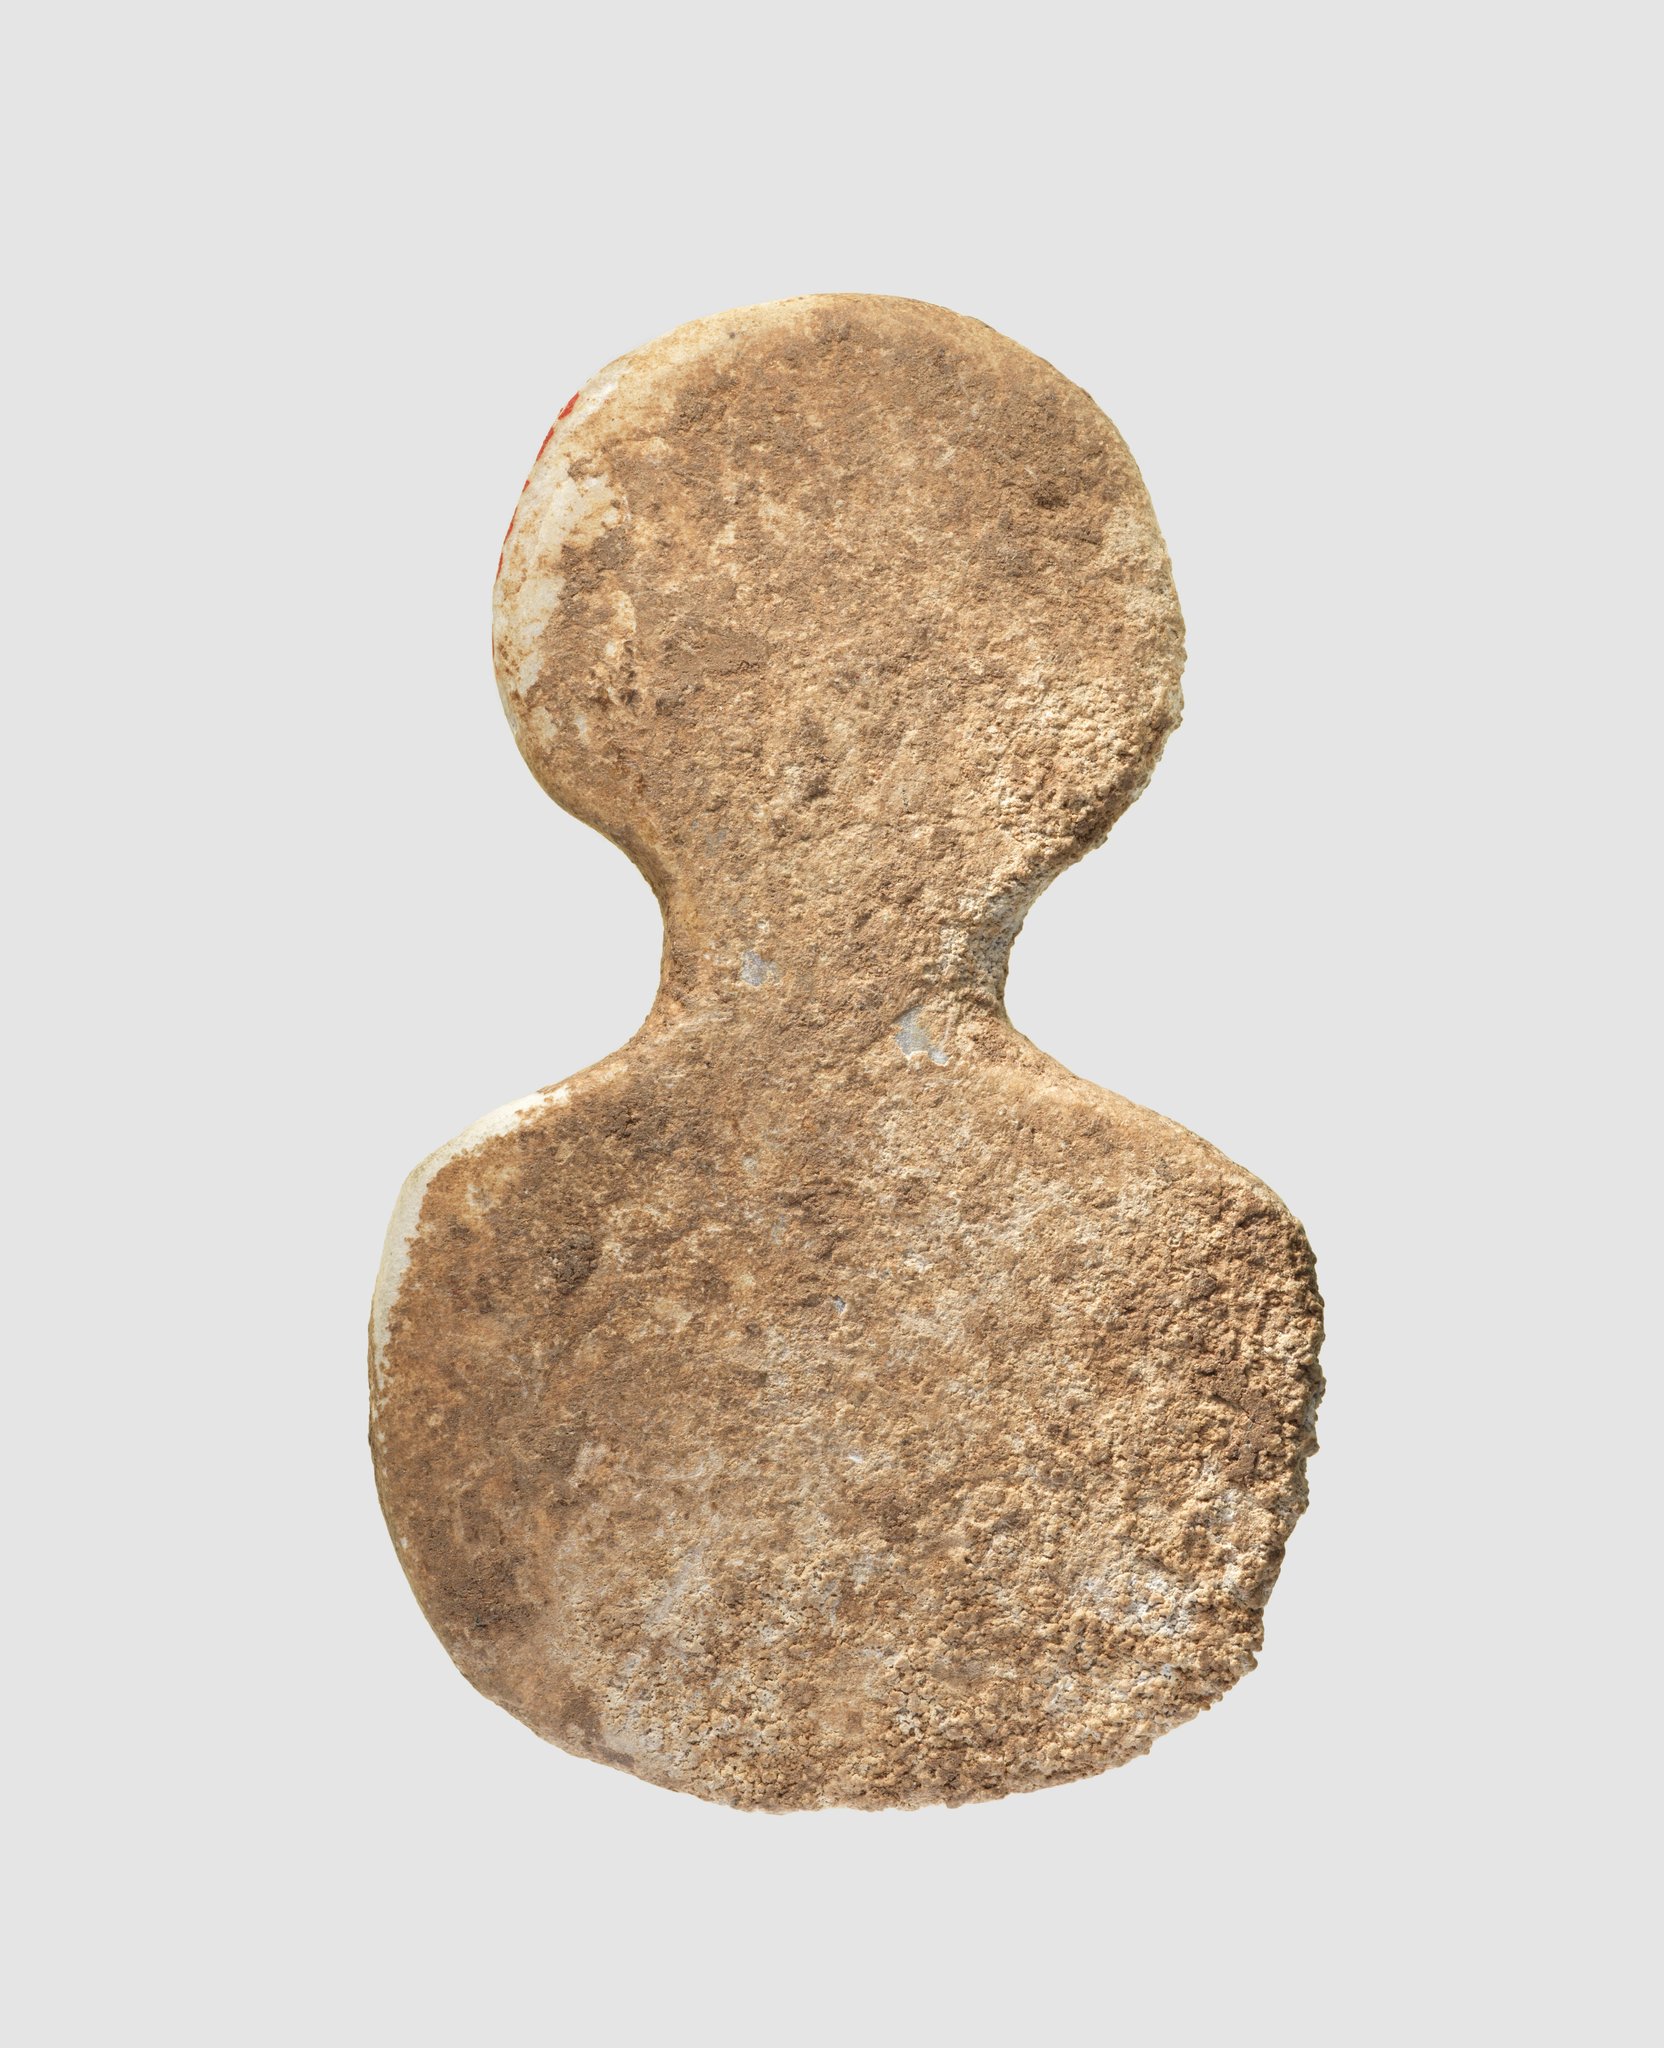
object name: sculpture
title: Spade-shaped schematic female (?) figure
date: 3000-2800 BCE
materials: limestone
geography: anatolia